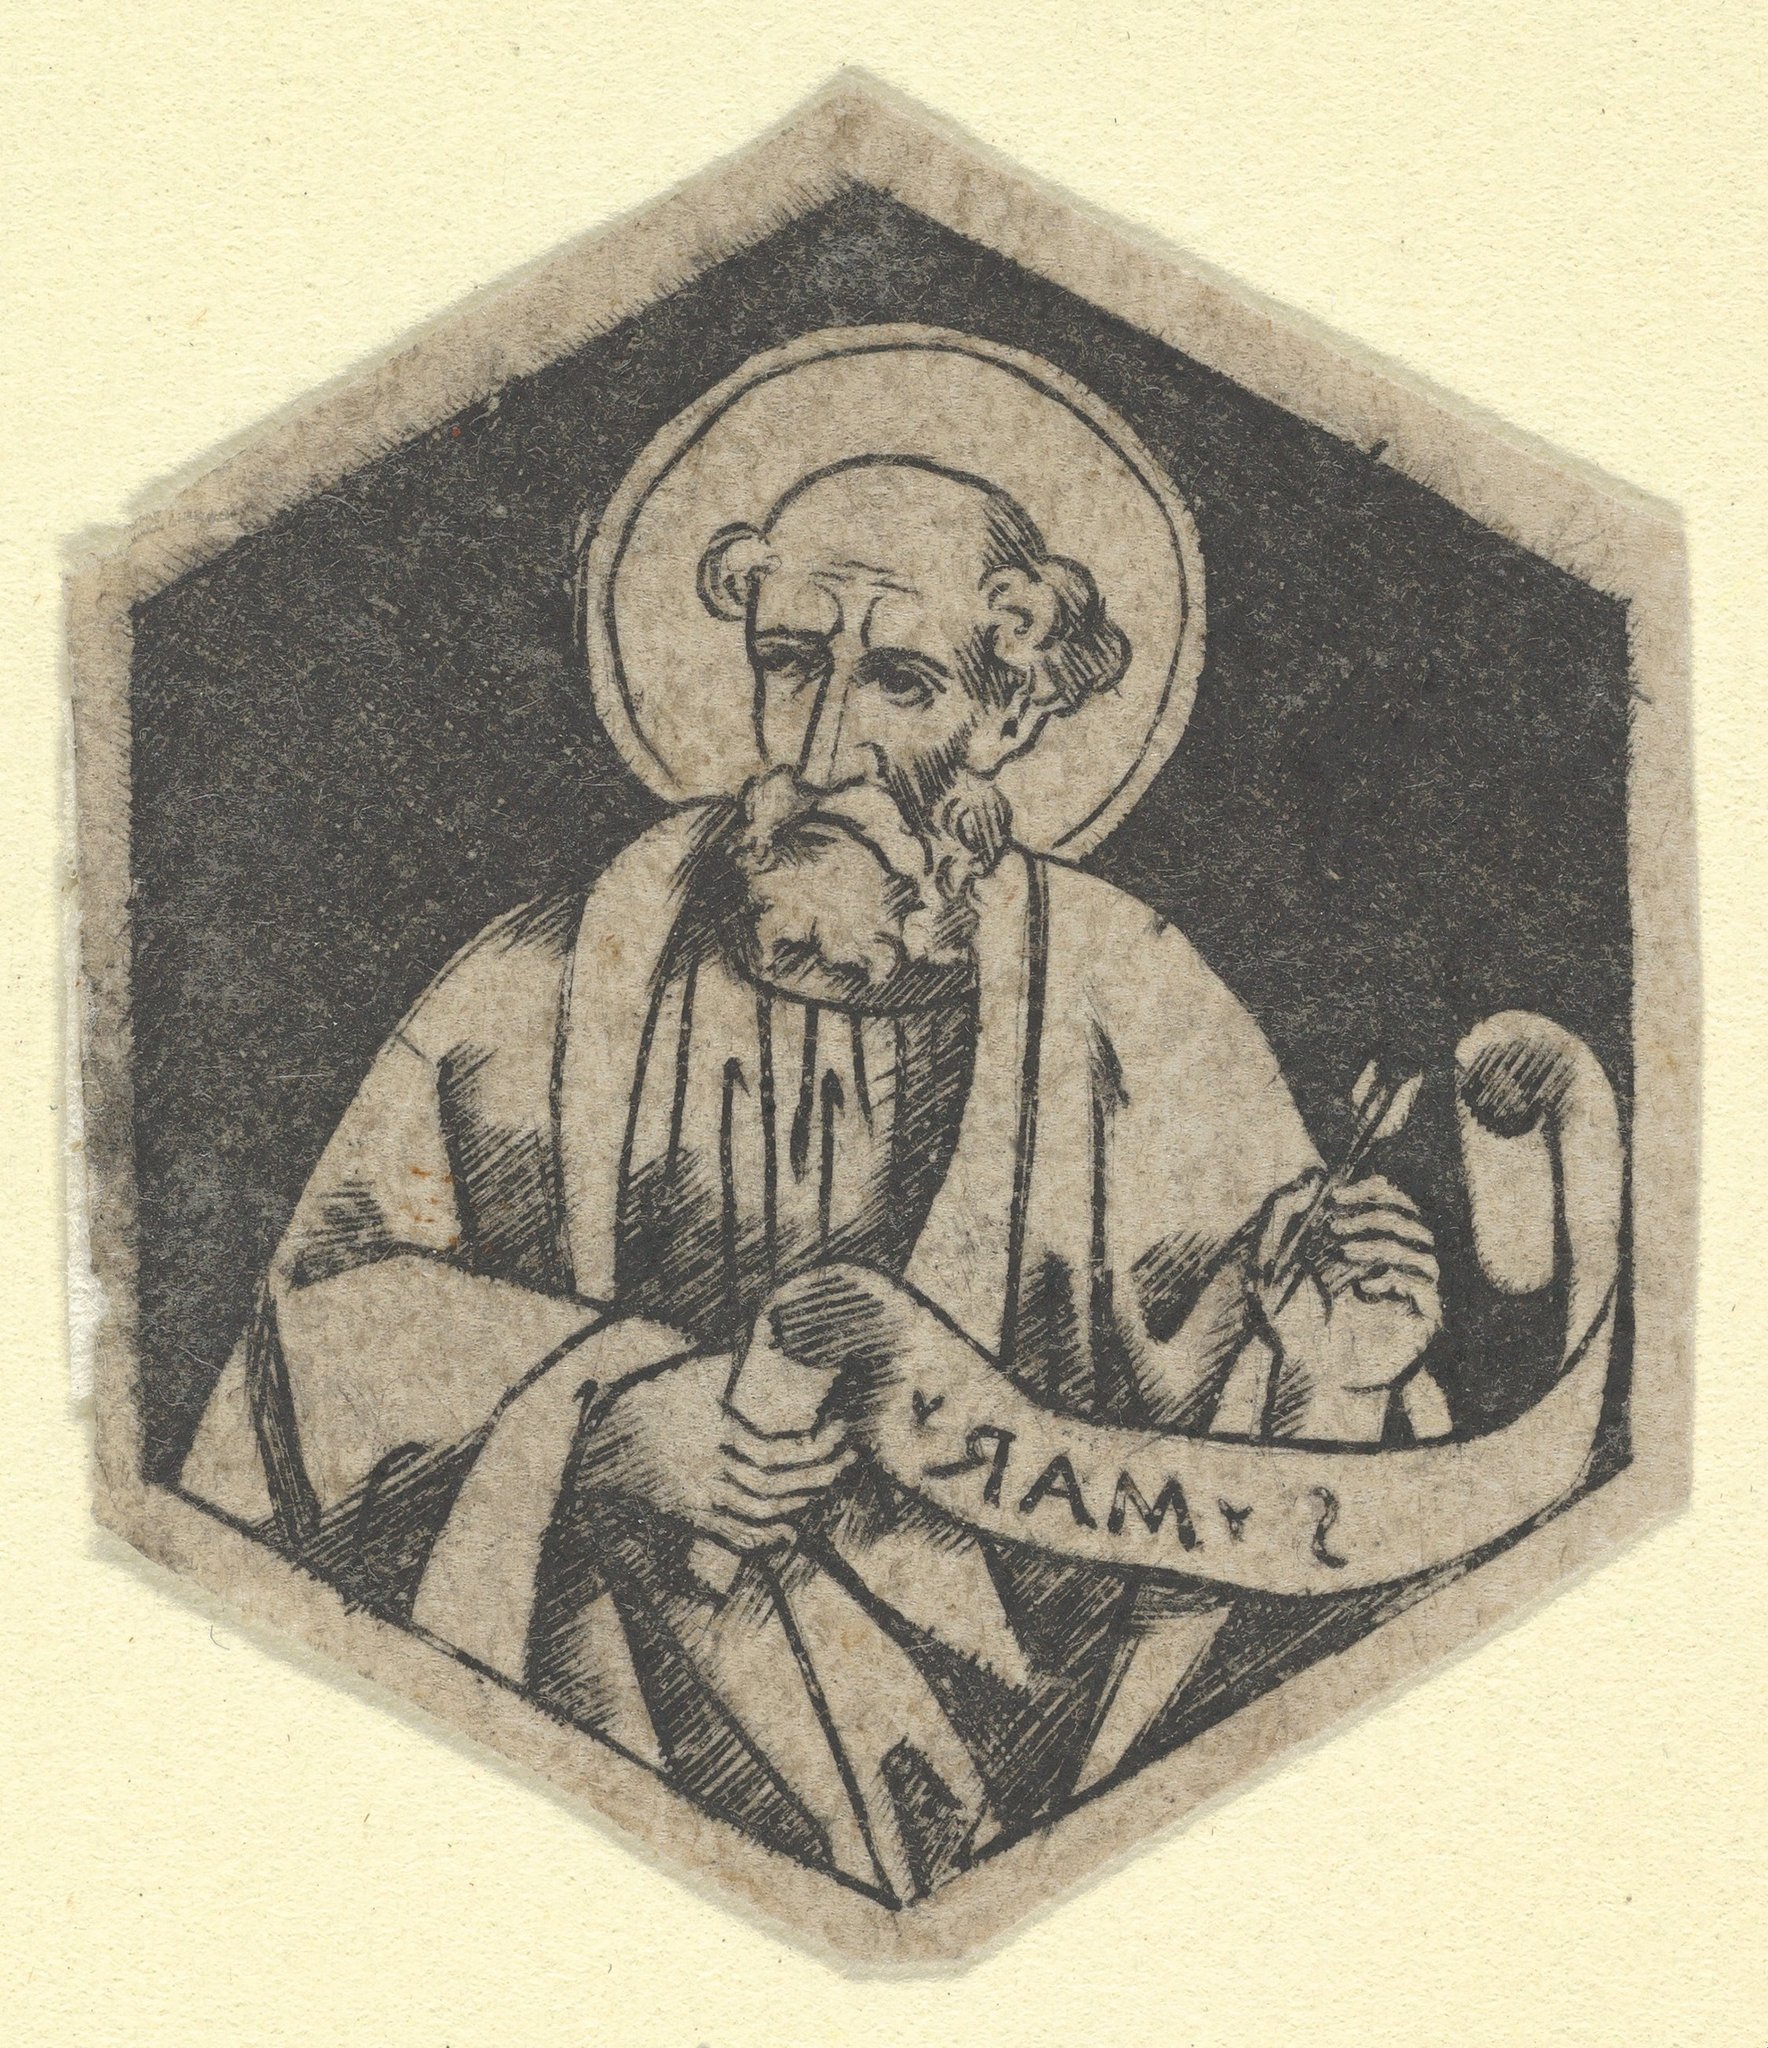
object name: print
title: St Mark the Evangelist, holding a banderole (possibly a modern impression)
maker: Anonymous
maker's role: artist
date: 1480-1520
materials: niello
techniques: engraving, printing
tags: portraits,saint mark